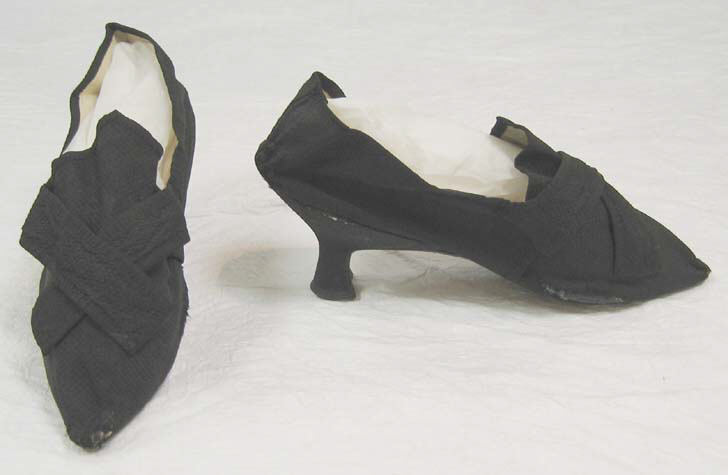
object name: shoe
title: Shoes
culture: british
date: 1701-1800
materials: leather, linen, silk